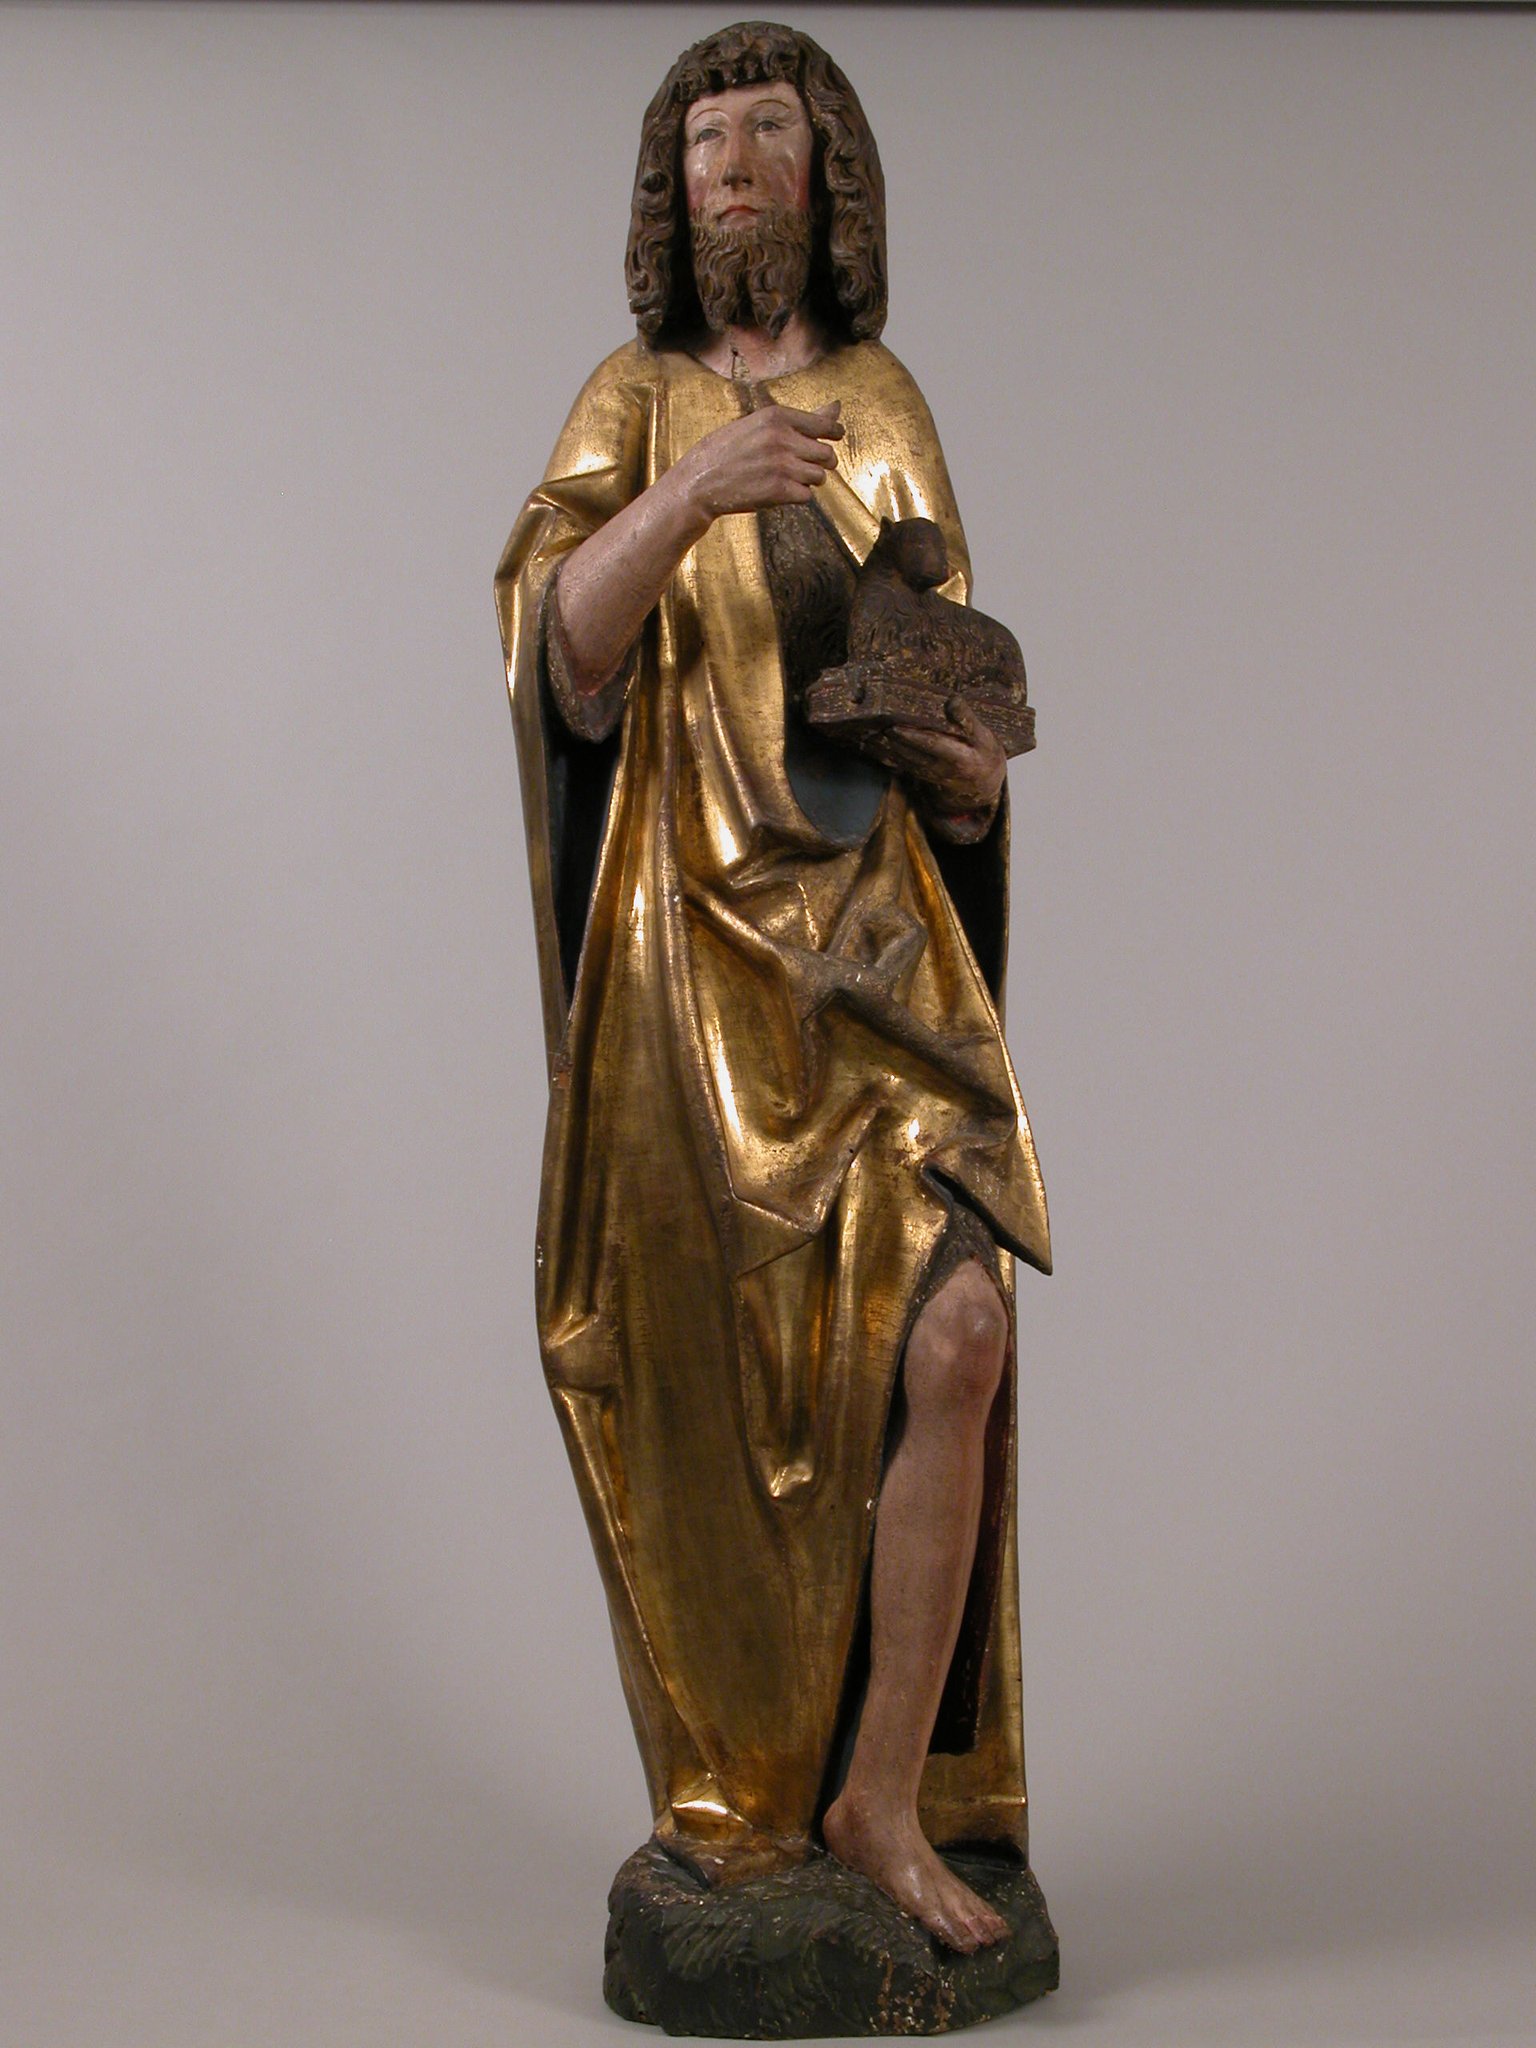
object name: statue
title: Saint John the Baptist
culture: german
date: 1401-1600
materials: paint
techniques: gilding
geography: germany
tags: lambs